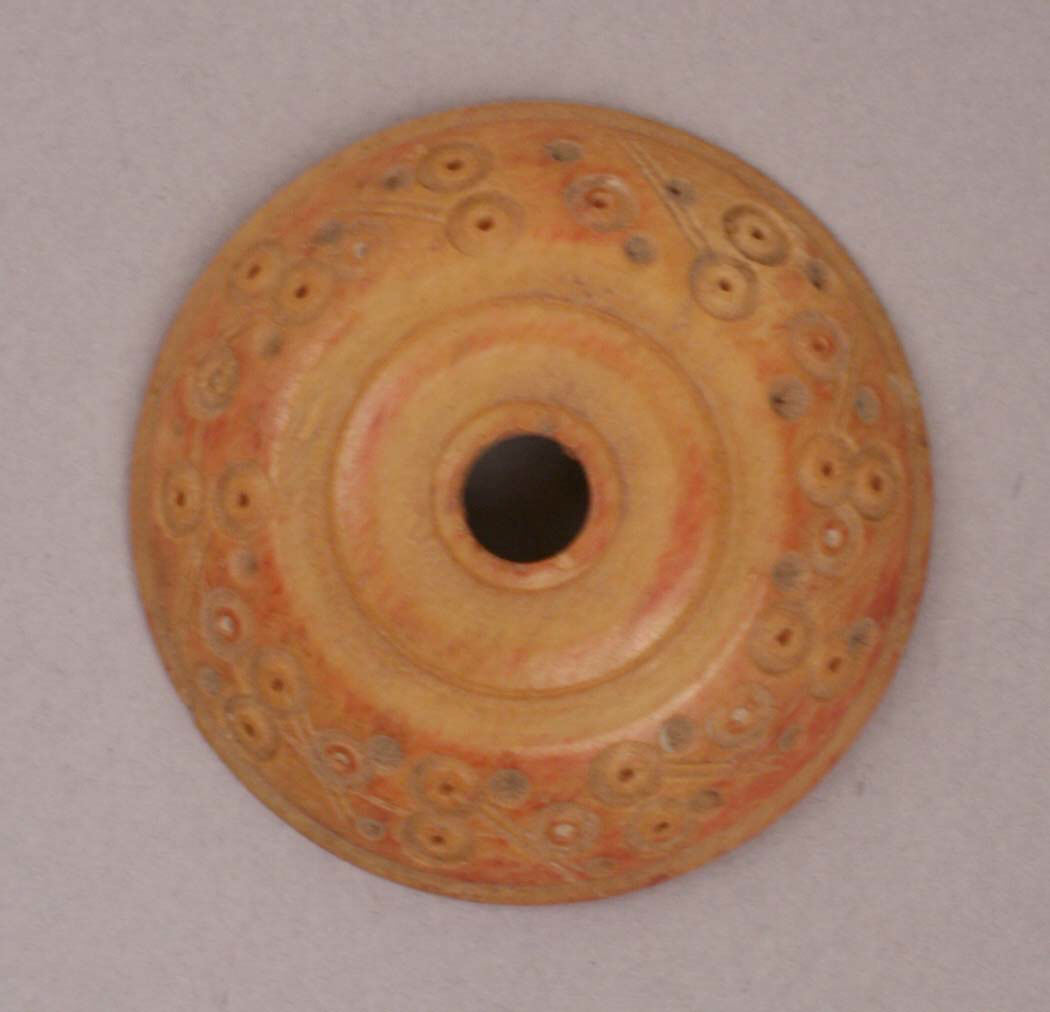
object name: button or bead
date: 801-1000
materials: bone, paint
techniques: incising, inlay, tinting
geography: iran